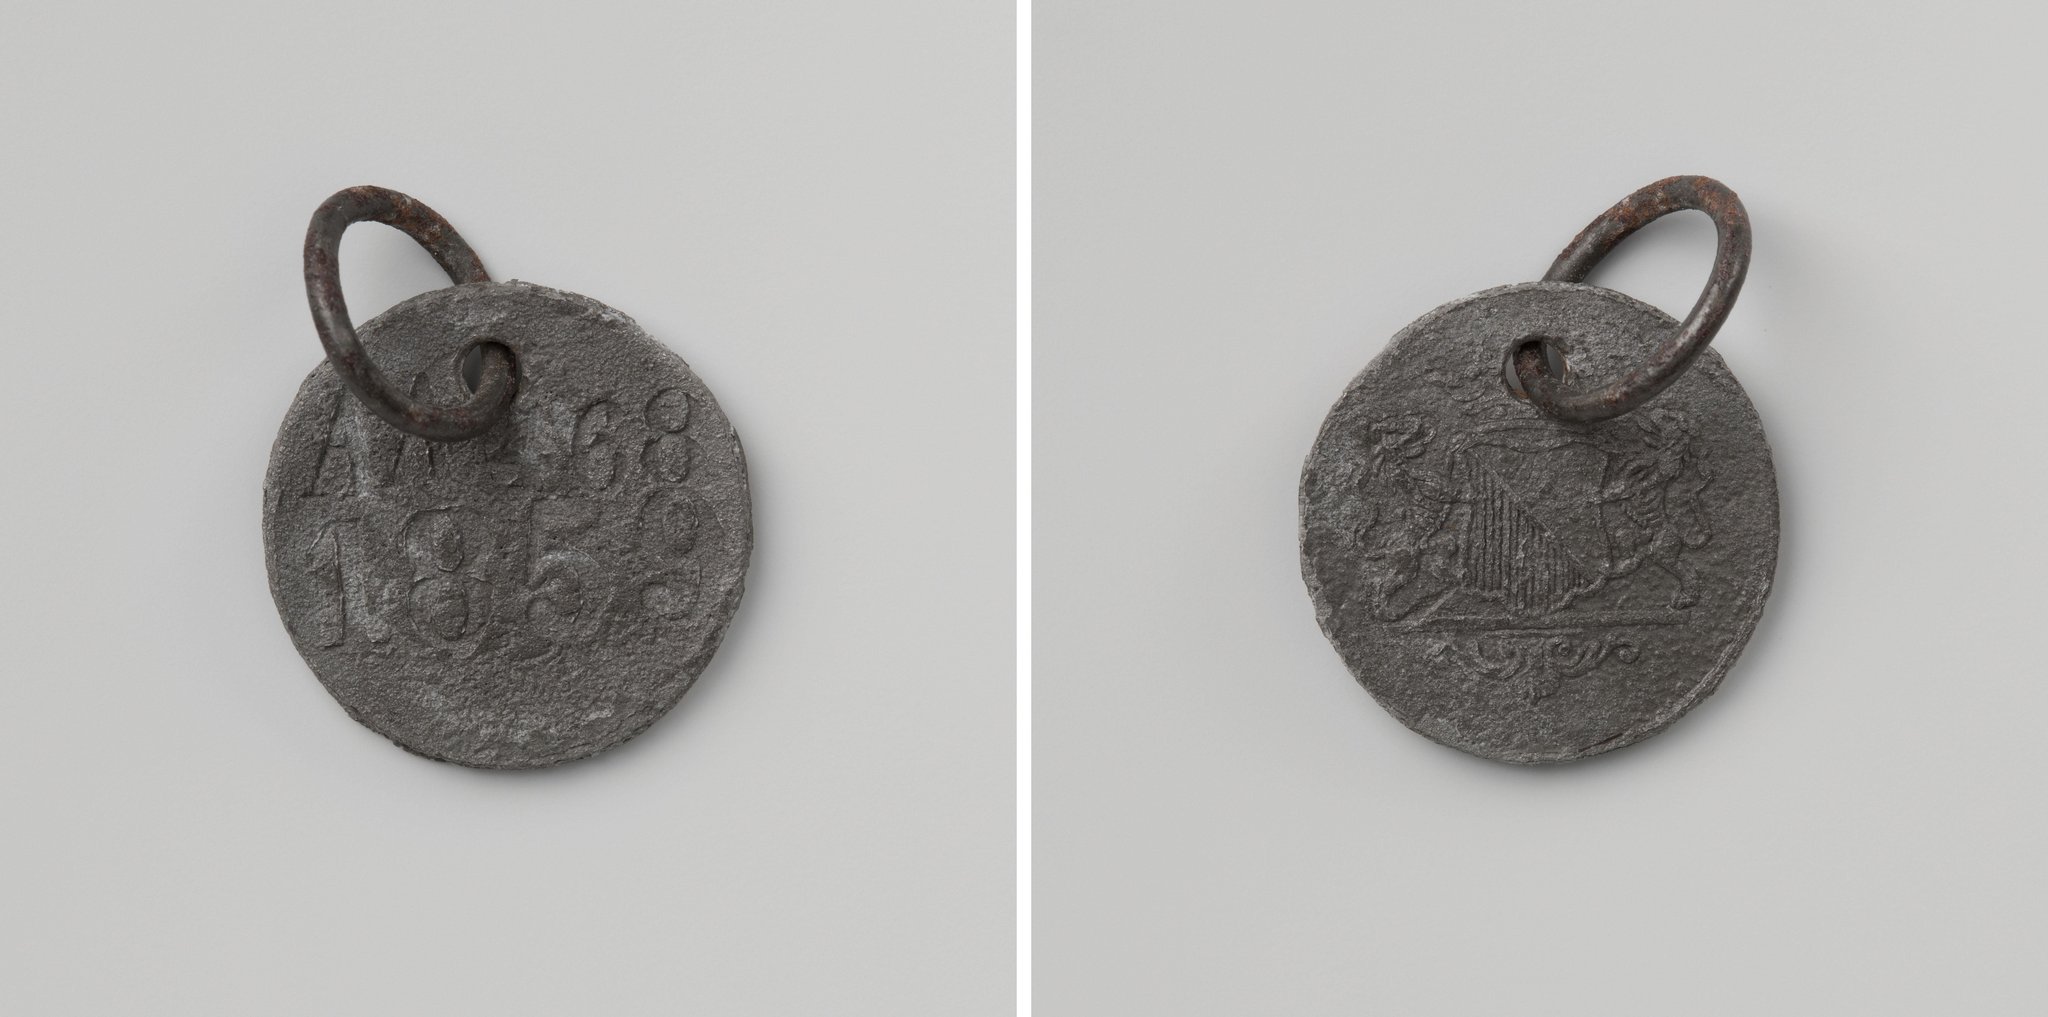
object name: tax token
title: Stad Utrecht, loodje met letter AA en no. 468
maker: Anonymous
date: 1859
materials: lead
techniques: striking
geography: utrecht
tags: utrecht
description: loodje met gat erin aan draagring. Voorzijde: letters AA en cijfer 468 boven jaartal. Keerzijde: gekroond wapenschild, geflankeerd door twee leeuwen